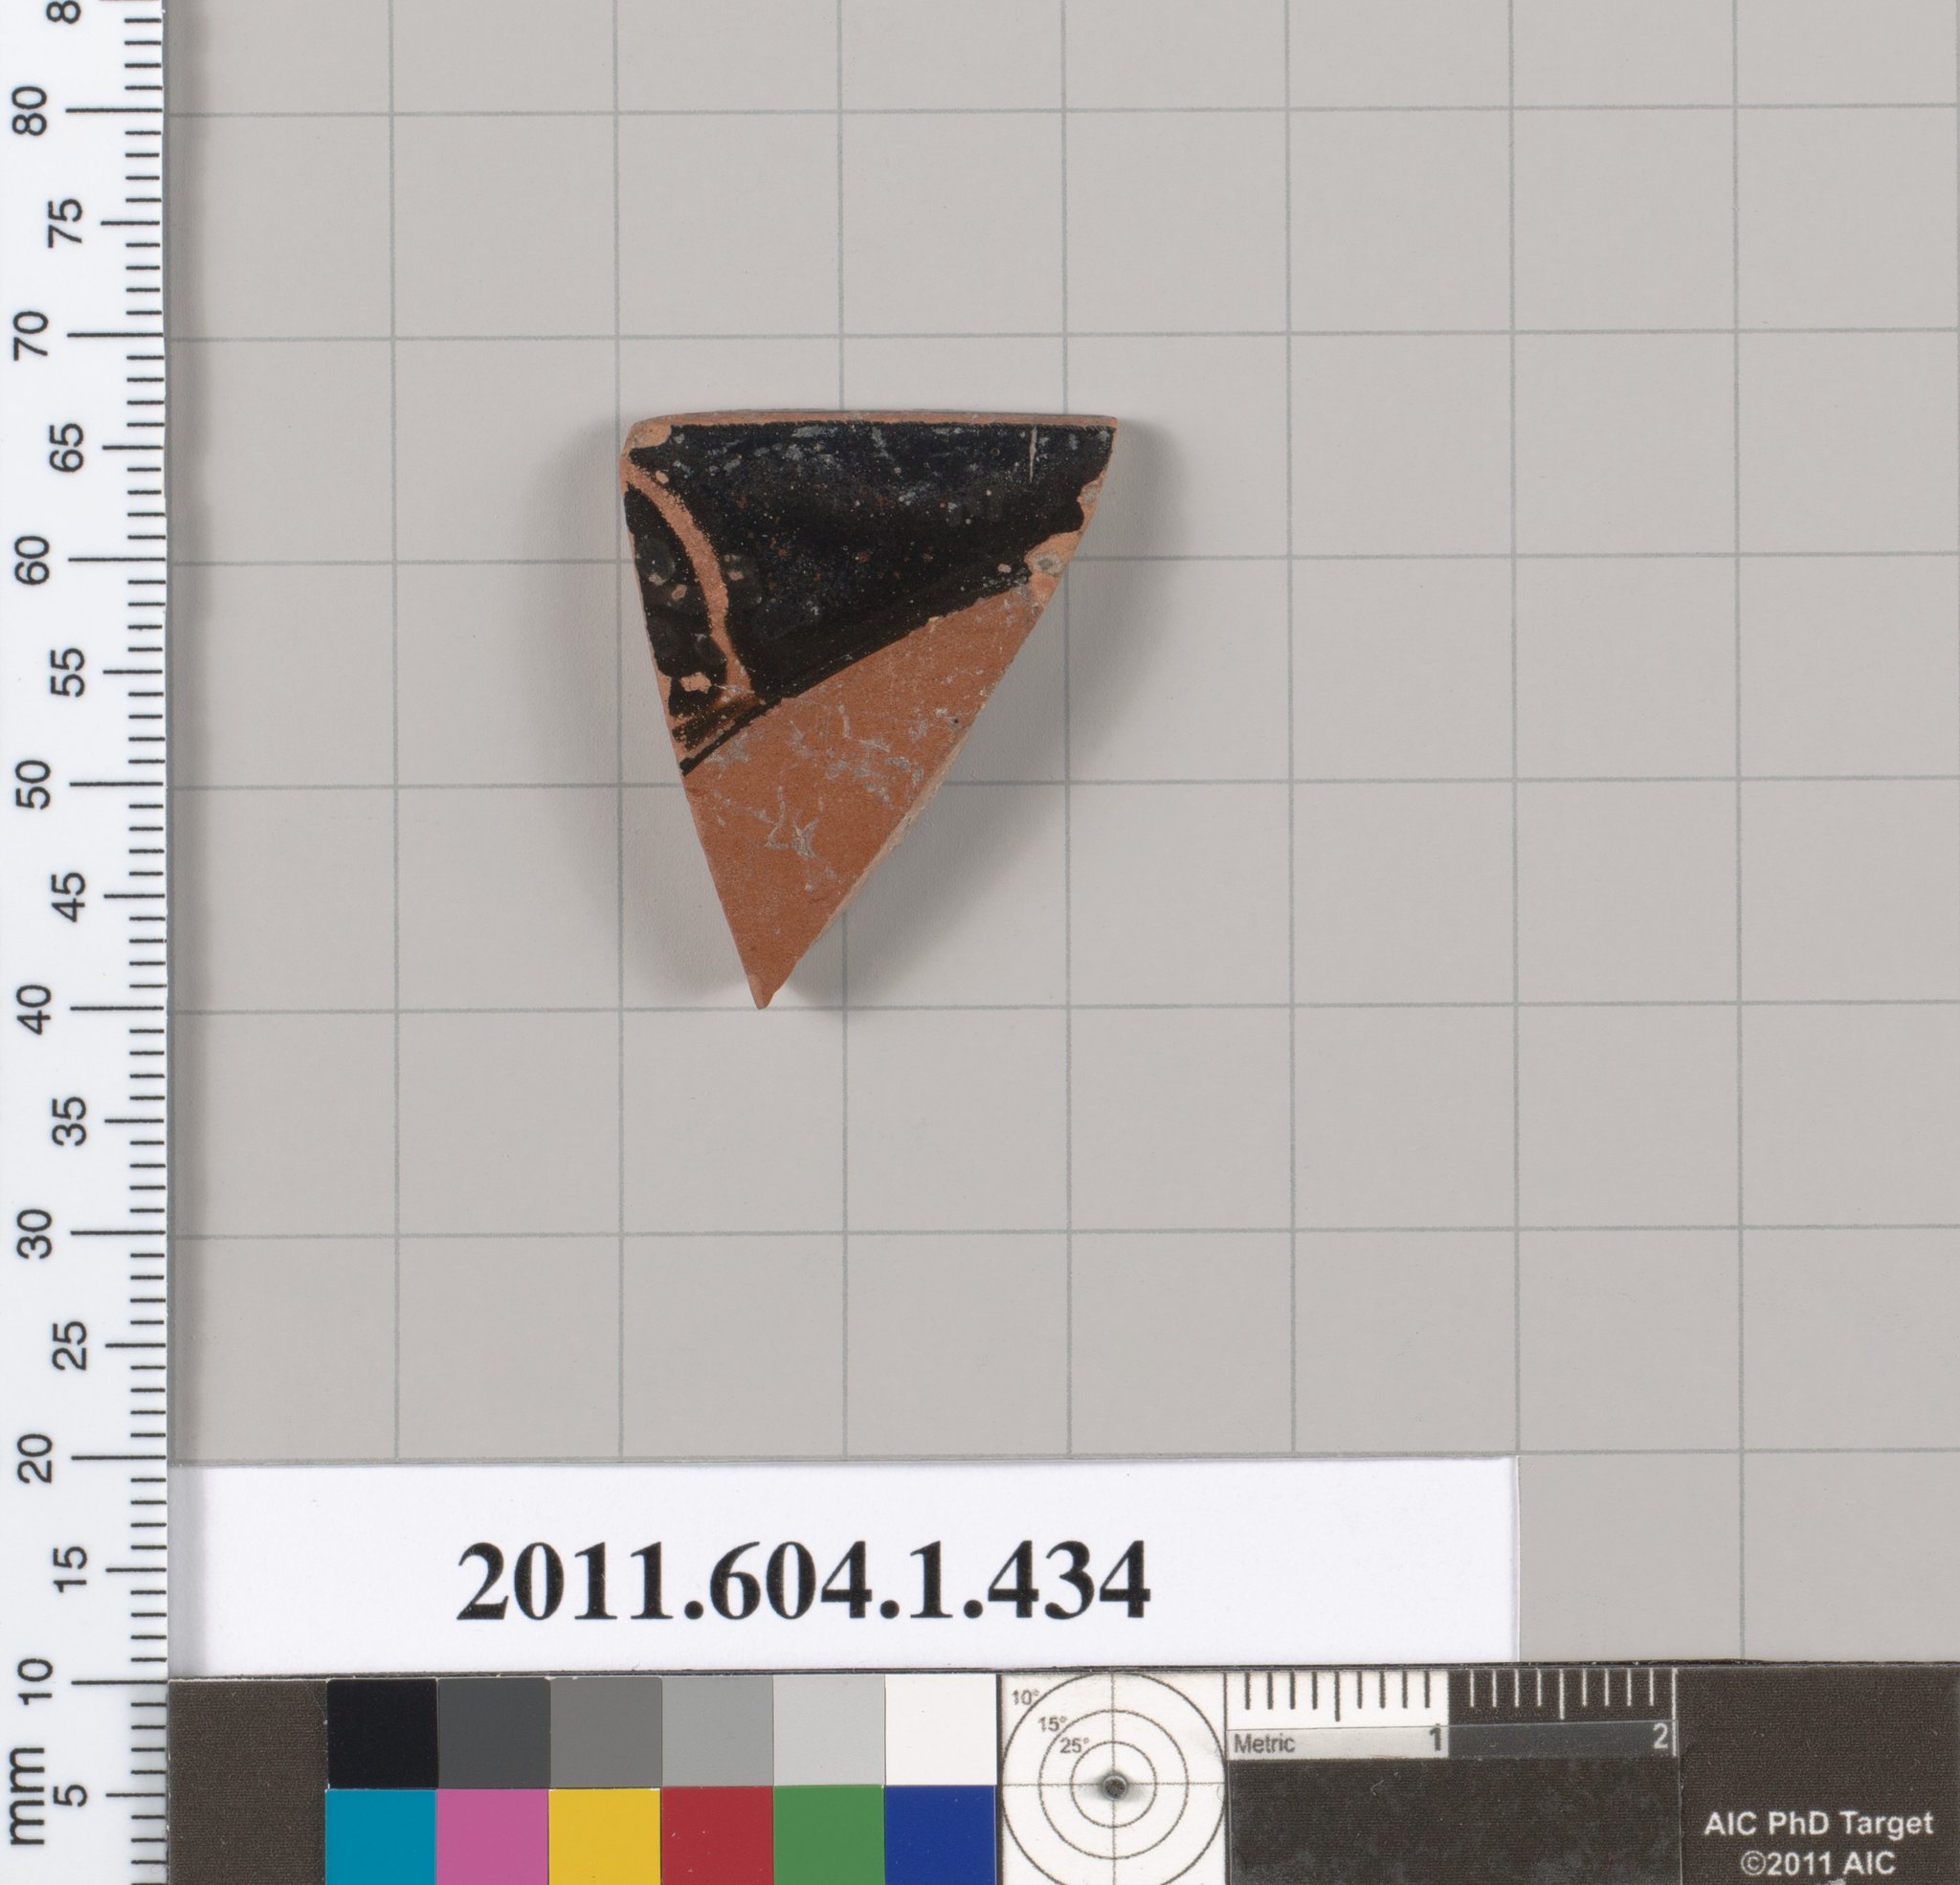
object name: kylix fragment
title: Terracotta rim fragment of a kylix (drinking cup)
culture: greek, attic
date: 475-451 BCE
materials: terracotta